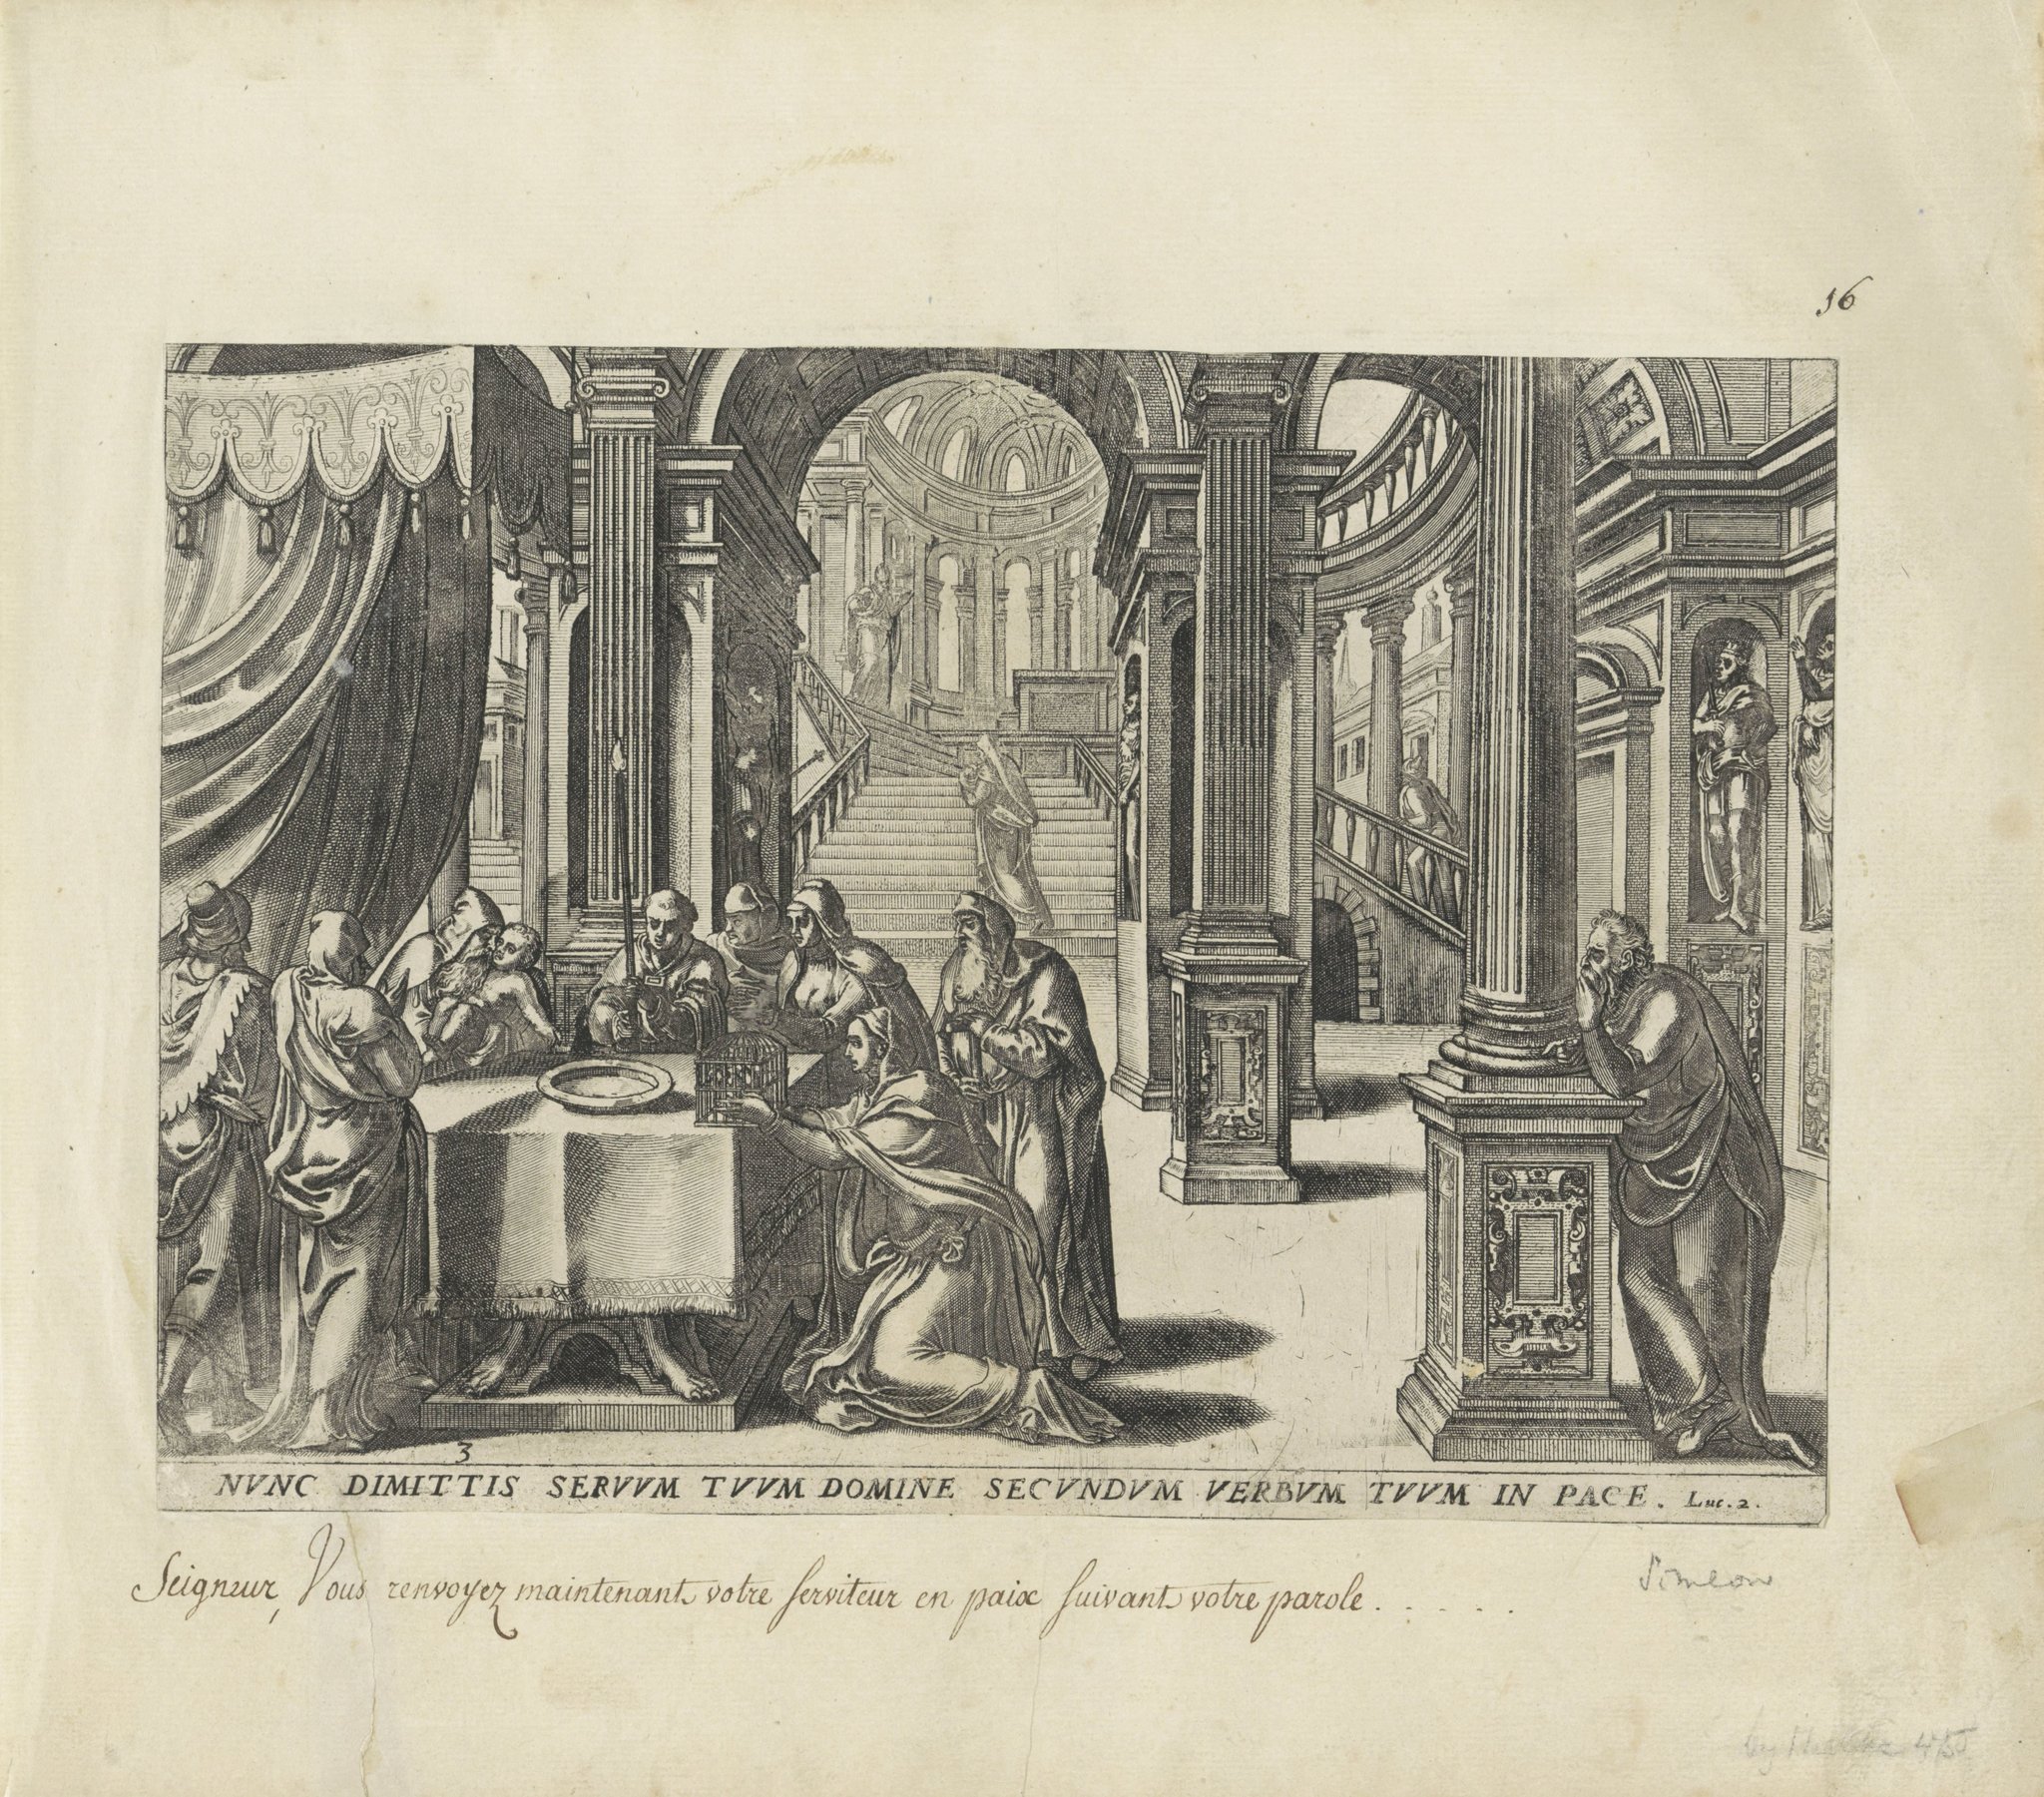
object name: print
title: Thesaurus sacrarum historiarum veteris testamenti (...)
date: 1585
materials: paper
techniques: engraving, etching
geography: antwerp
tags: presentation of the christ-child in the temple, usually simeon (and anna) present (luke 2:22-39)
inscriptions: collector's mark: Lugt 2228, inscription: ‘Seigneur, Vous renvoyez maintenant votre serviteur en paix suivant votre parole ....’, number: ‘16’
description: In de tempel staat om het altaar een groep mensen. De hogepriester Simeon houdt het Christuskind in zijn armen. Maria presenteert geknield de vogelkooi met twee jonge duiven. Op de achtergrond is te zien hoe Maria met het Kind in haar armen naar Simeon toe loopt. Onder de voorstelling een verwijzing in het Latijn naar de Bijbeltekst in Luc. 2.